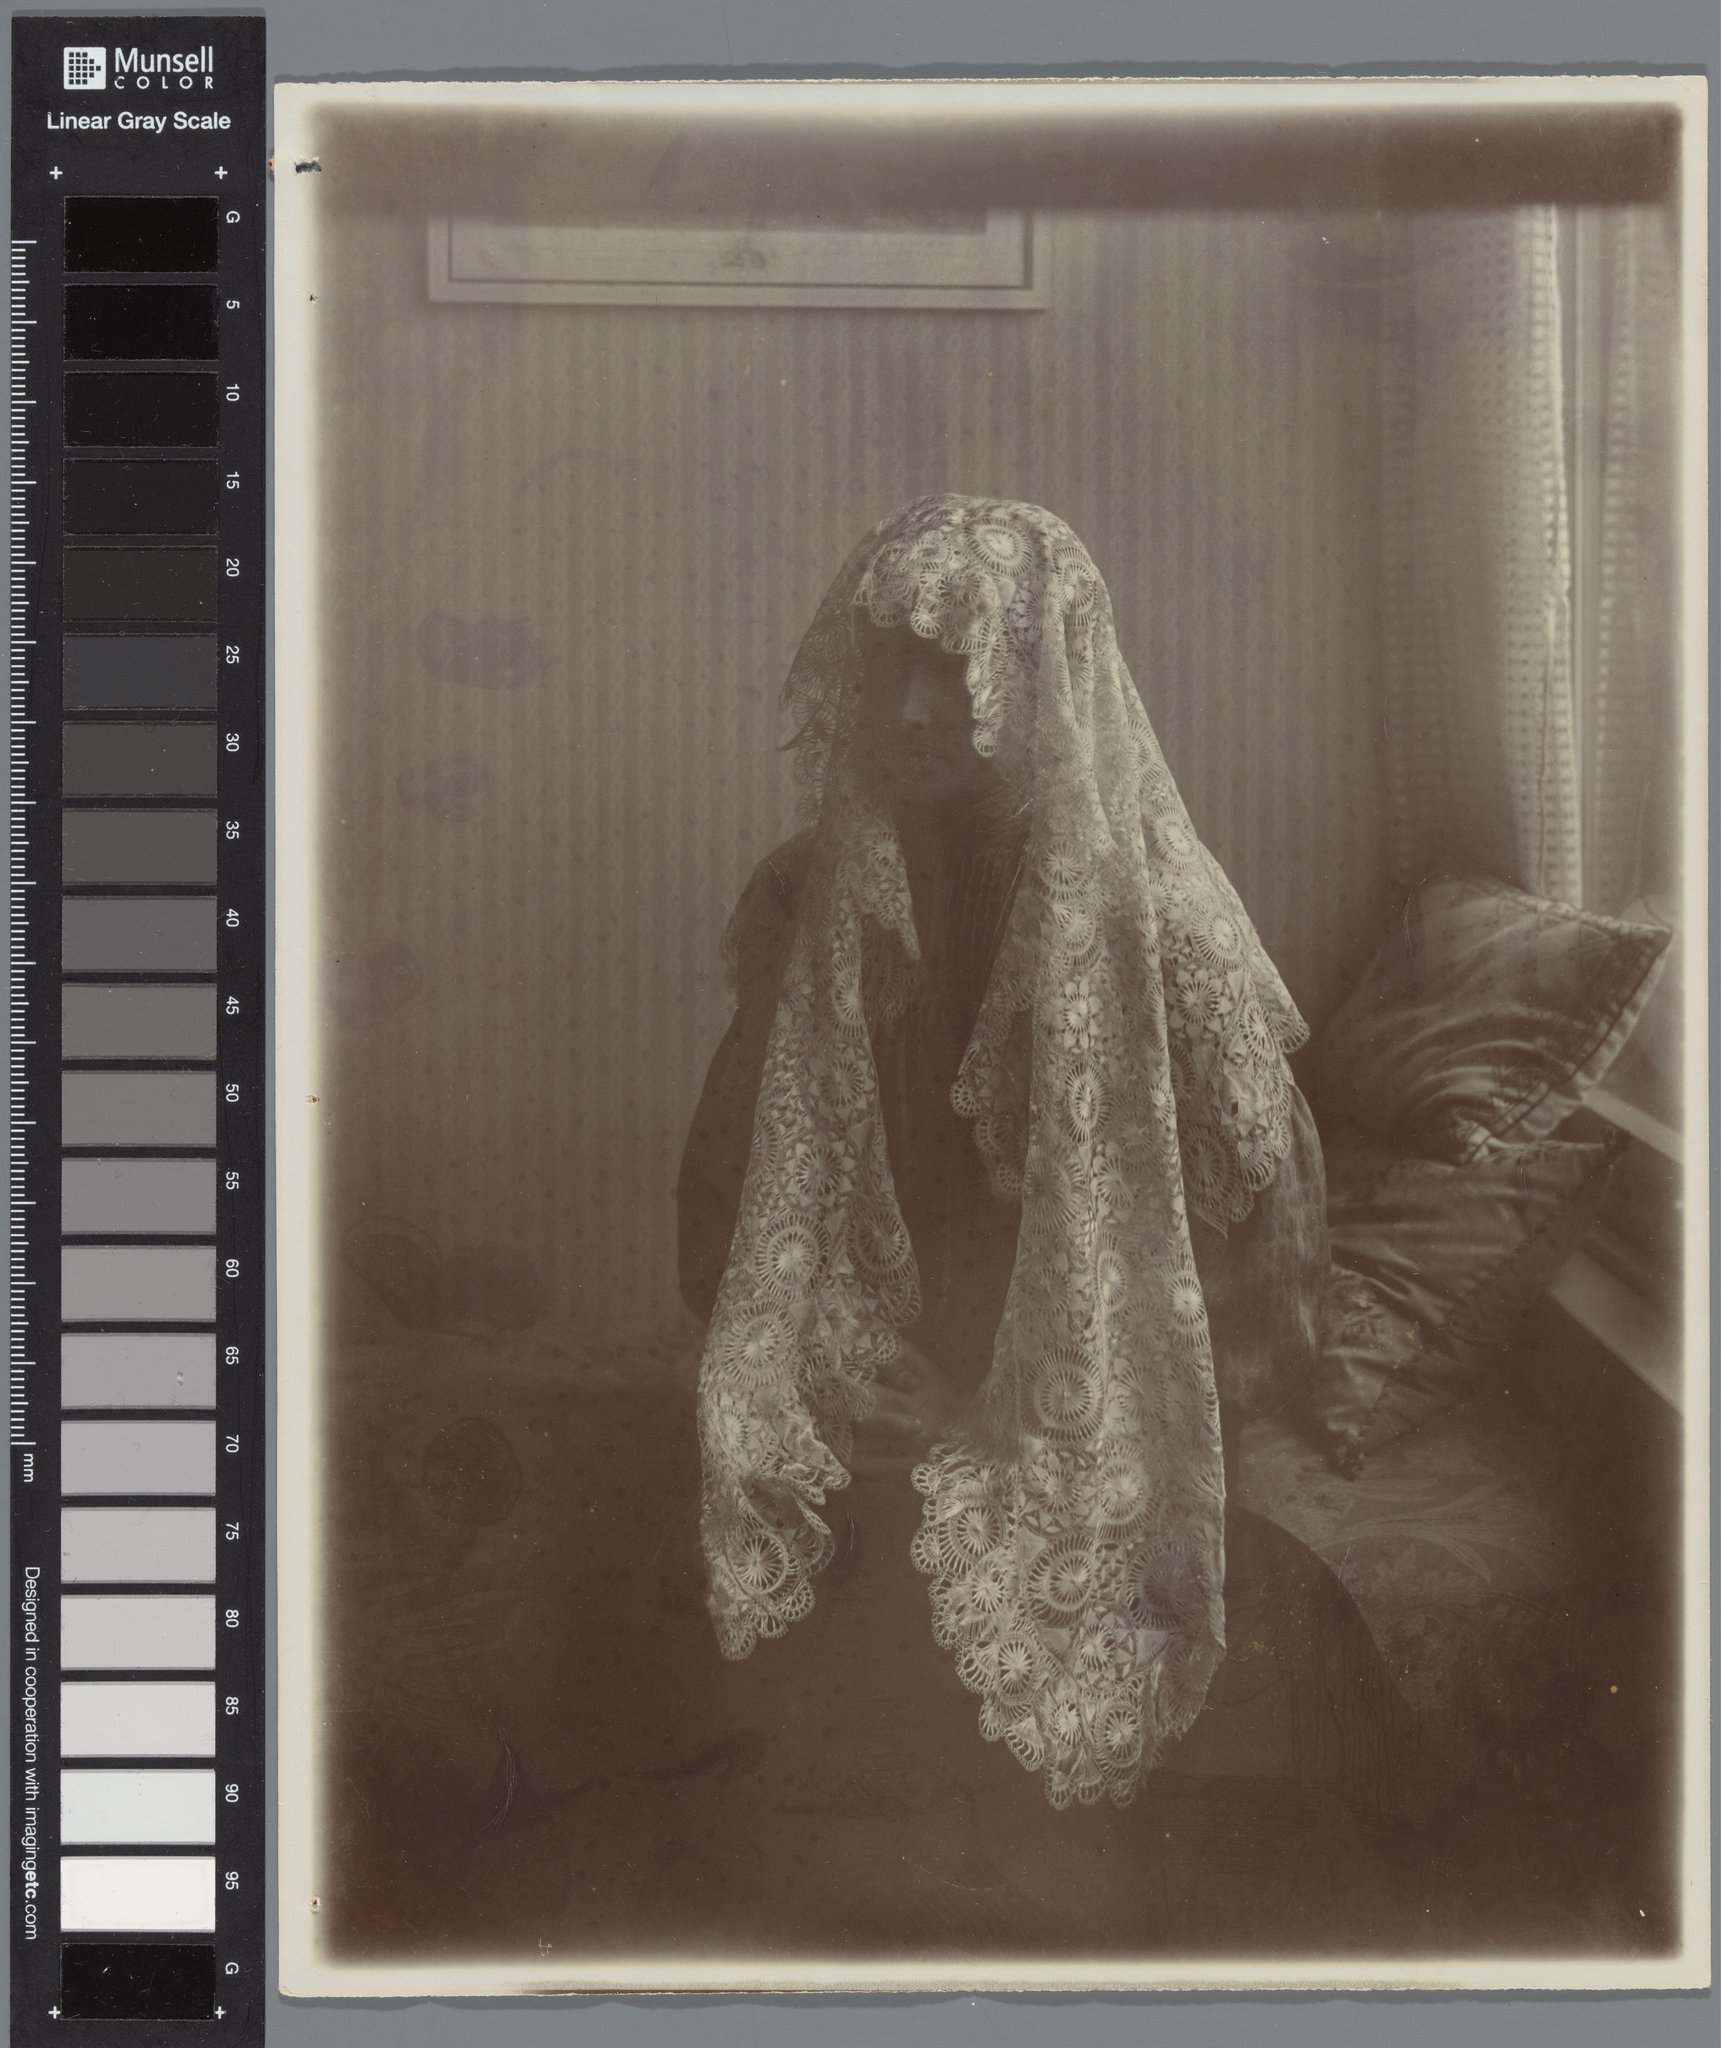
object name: photograph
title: Portret van een onbekende vrouw met een kanten sluier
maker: Anonymous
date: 1890-1920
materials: paper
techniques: collodion silver print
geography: netherlands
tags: historical persons not known by name - bb - woman, lace, veil